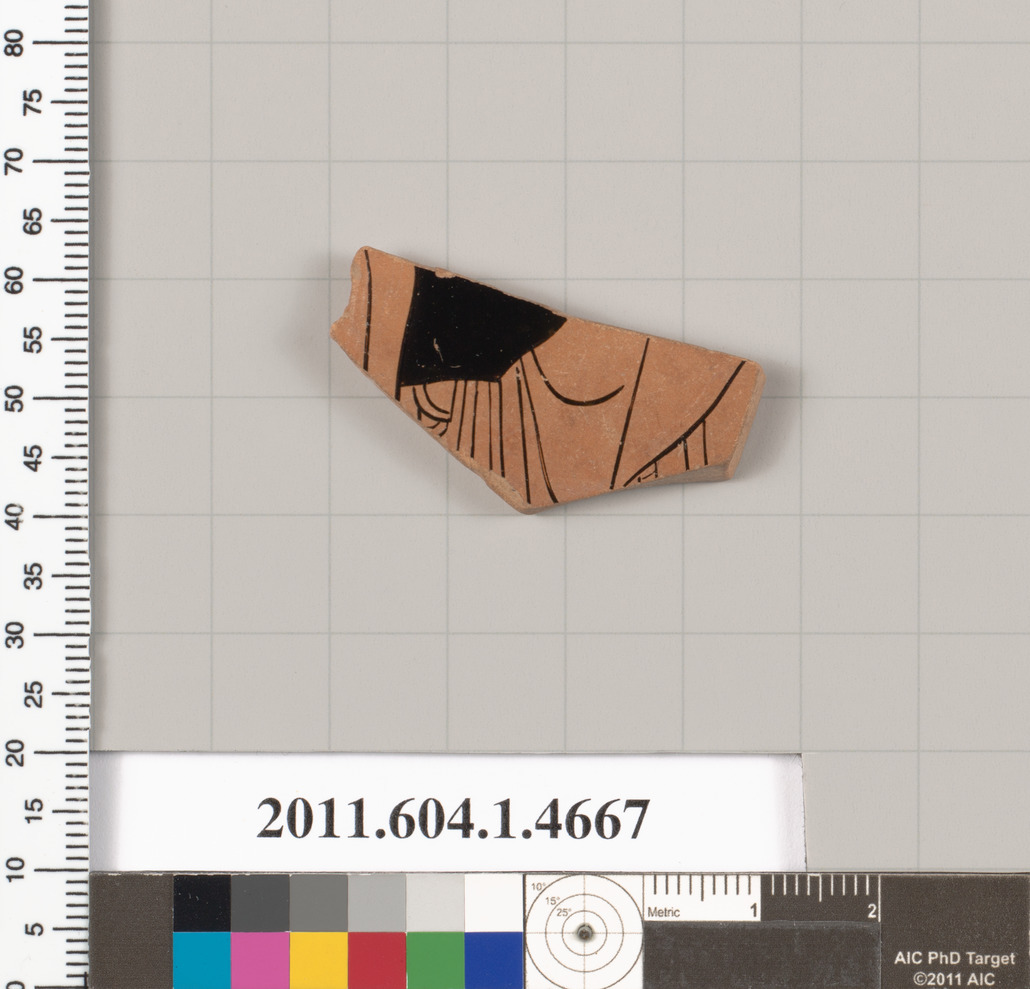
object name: kylix fragment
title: Terracotta fragment of a kylix (drinking cup)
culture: greek, attic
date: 480-470 BCE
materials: terracotta